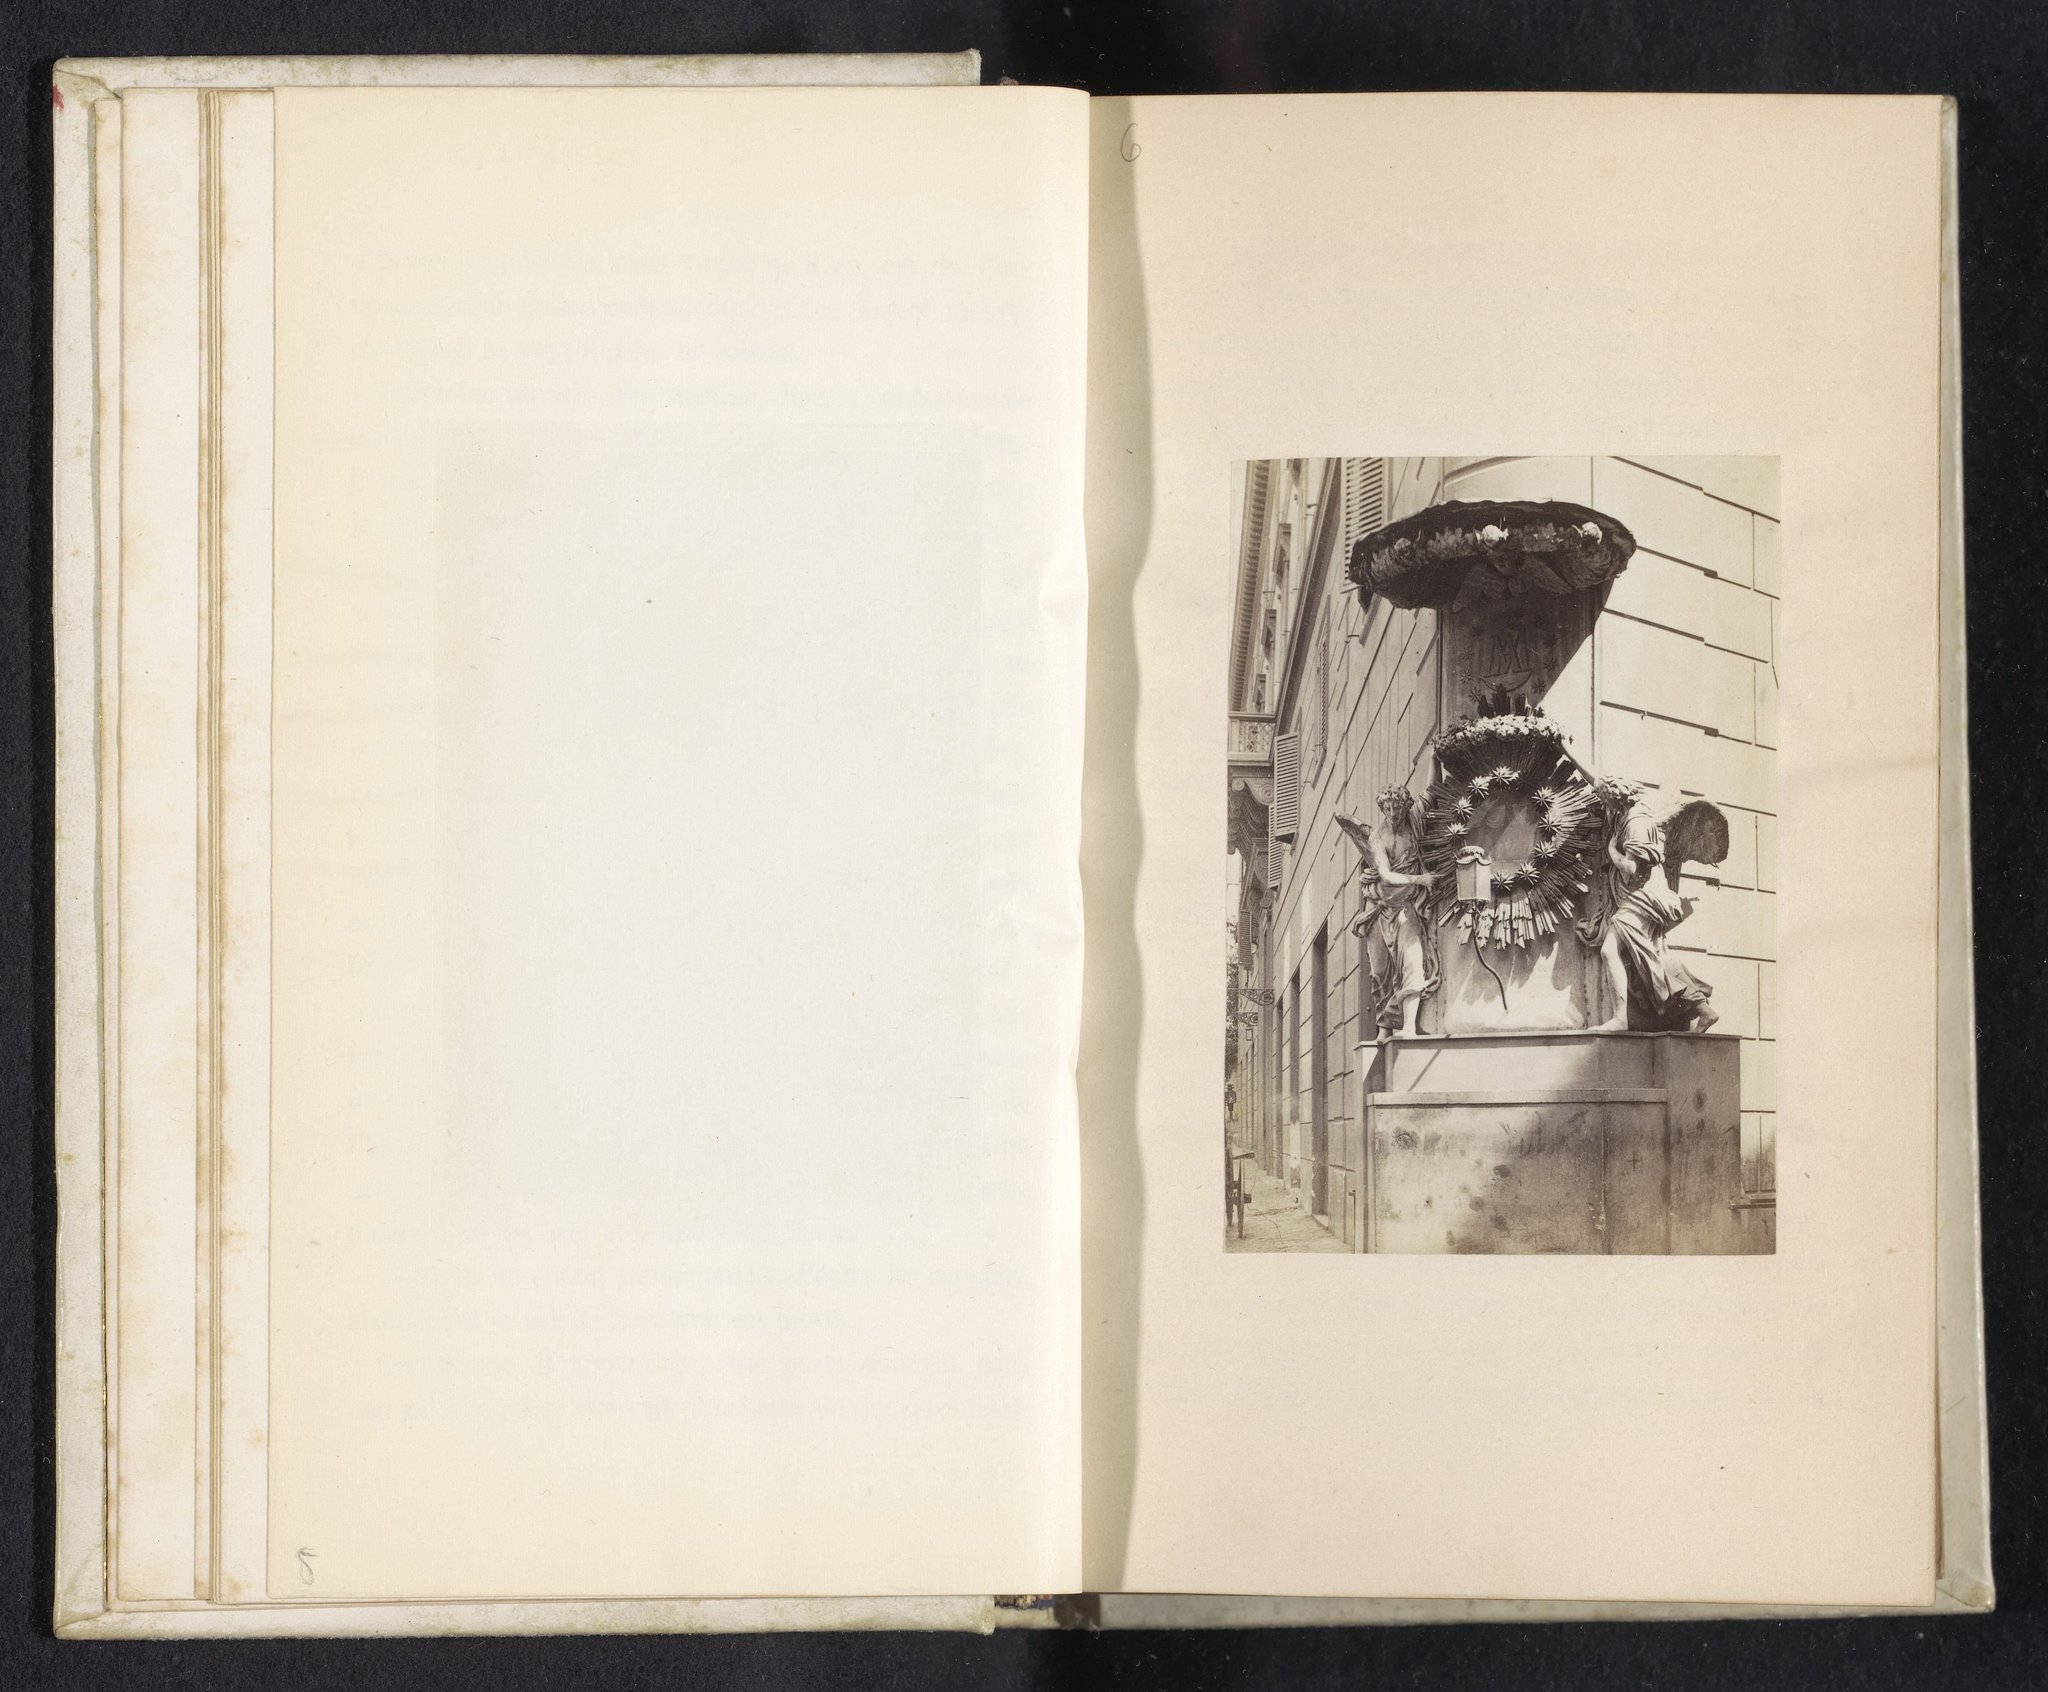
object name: page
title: Sculpturale omlijsting van een straatlantaarn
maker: Anonymous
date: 1850-1860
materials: photographic support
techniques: albumen print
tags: lantern, sculpture, façade (of house or building)